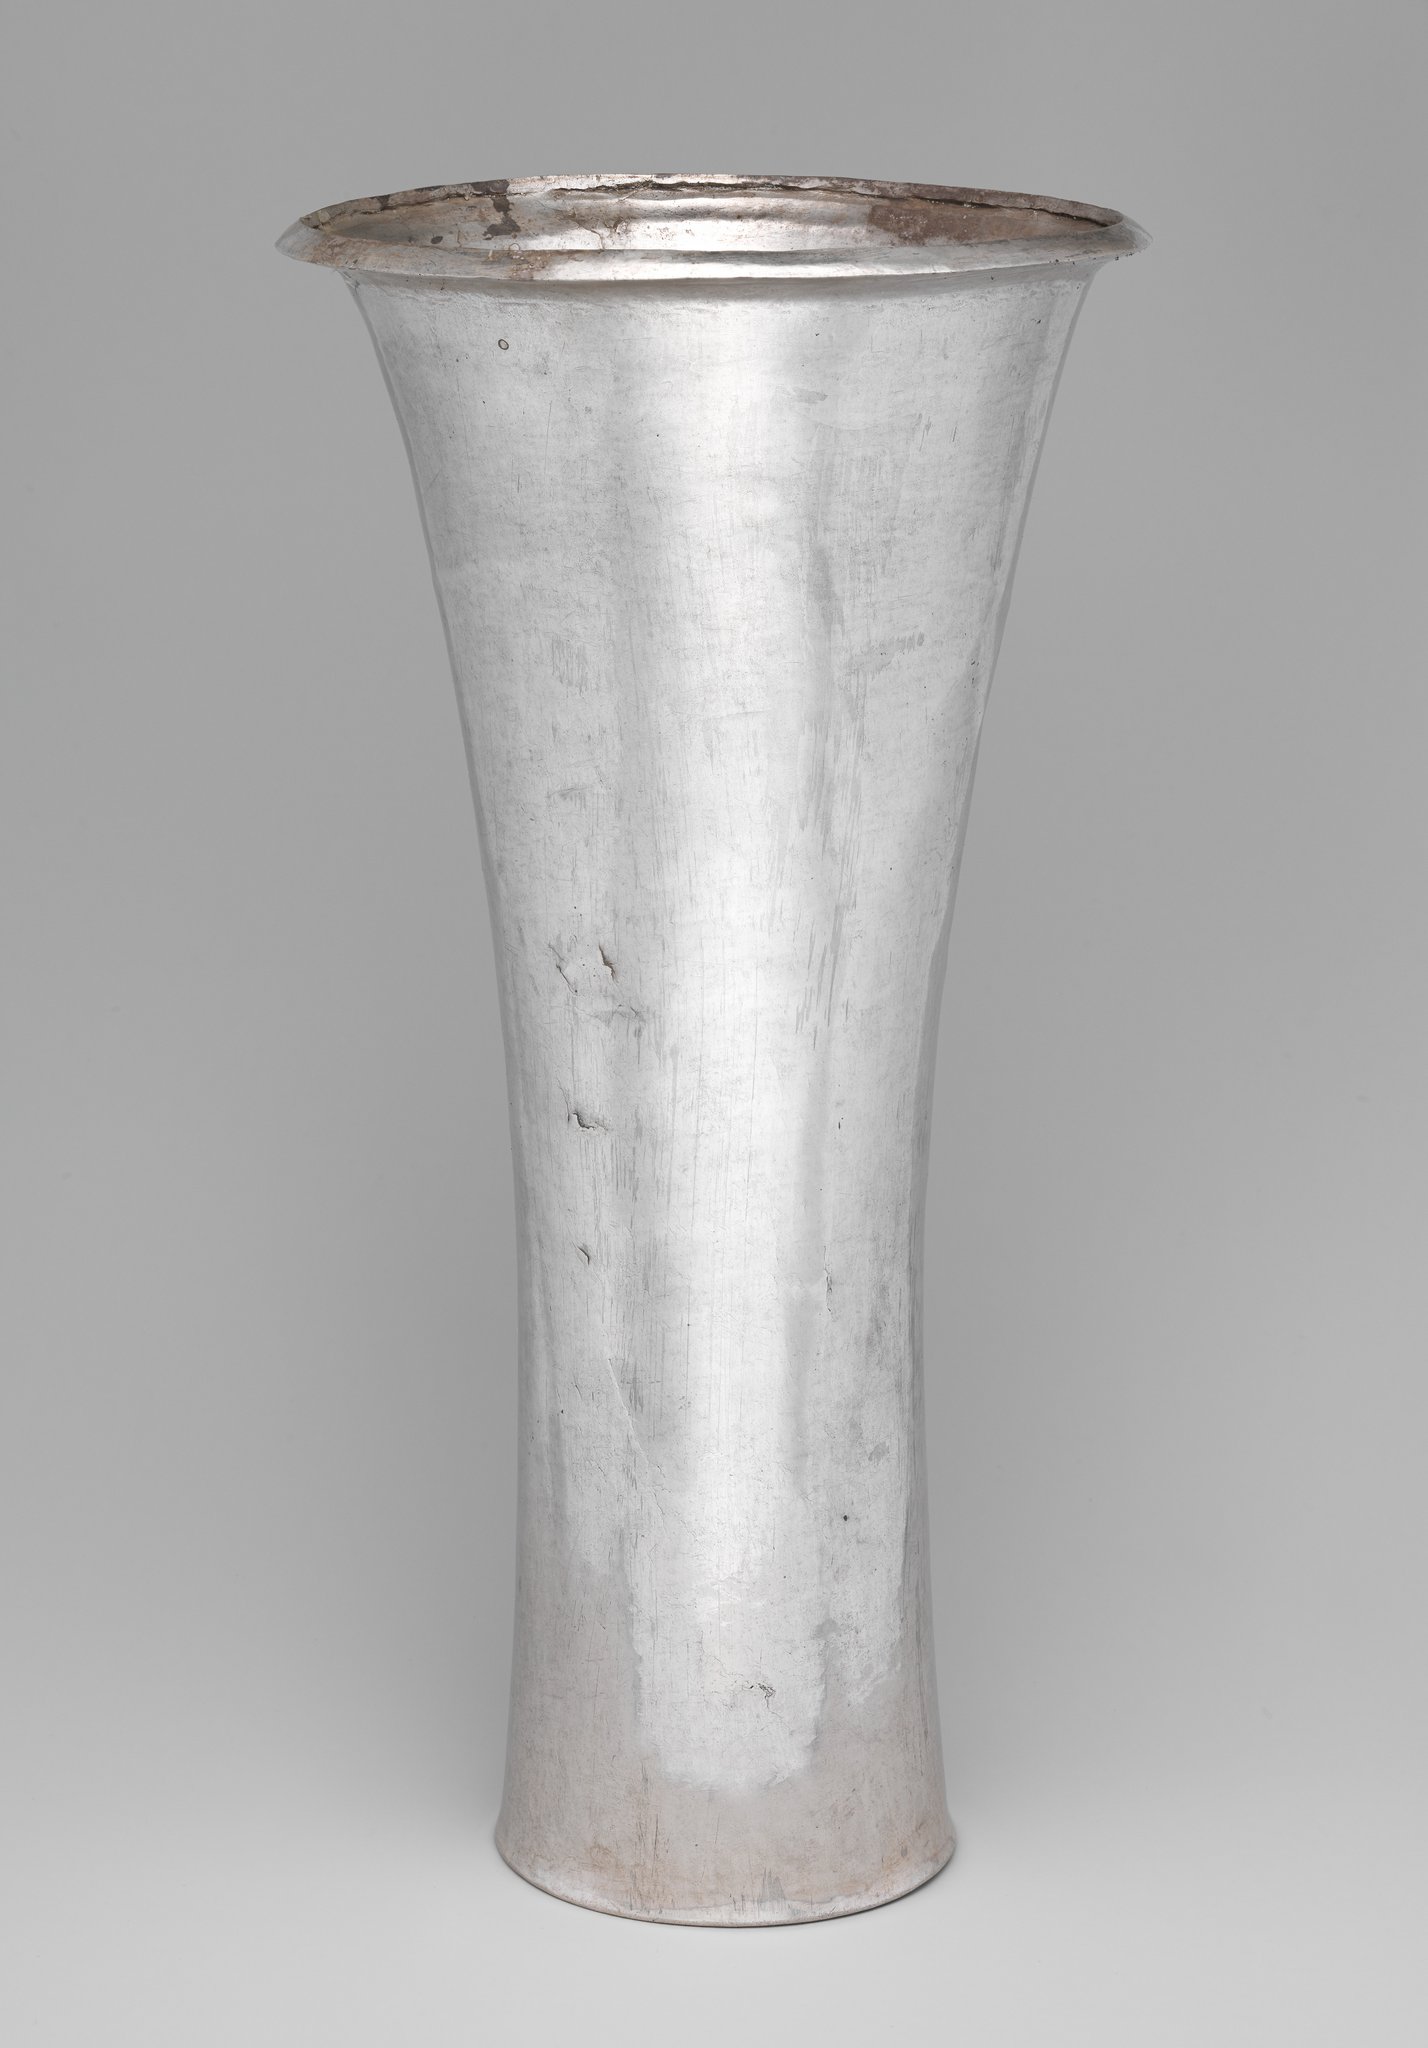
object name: beaker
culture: chimú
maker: chimú artist(s)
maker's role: artist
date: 1300-1470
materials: silver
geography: peru